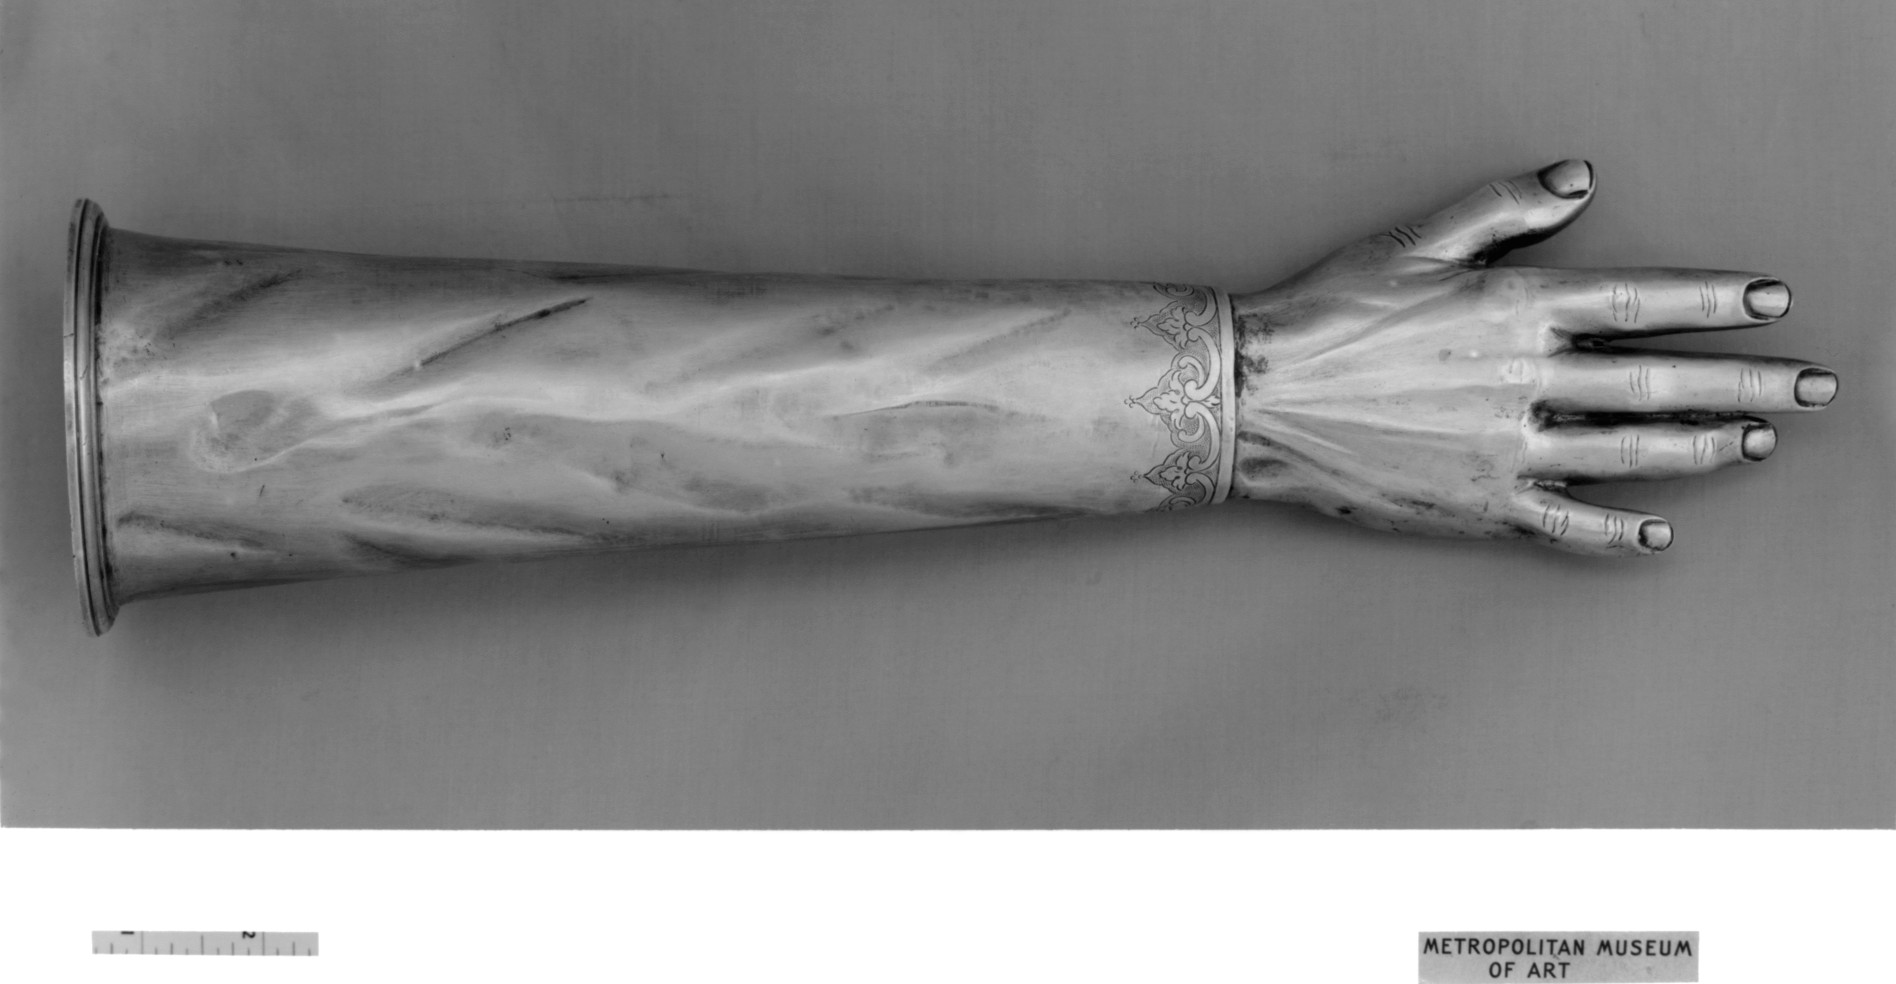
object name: reliquary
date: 1701-1800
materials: silver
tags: hands,reliquaries